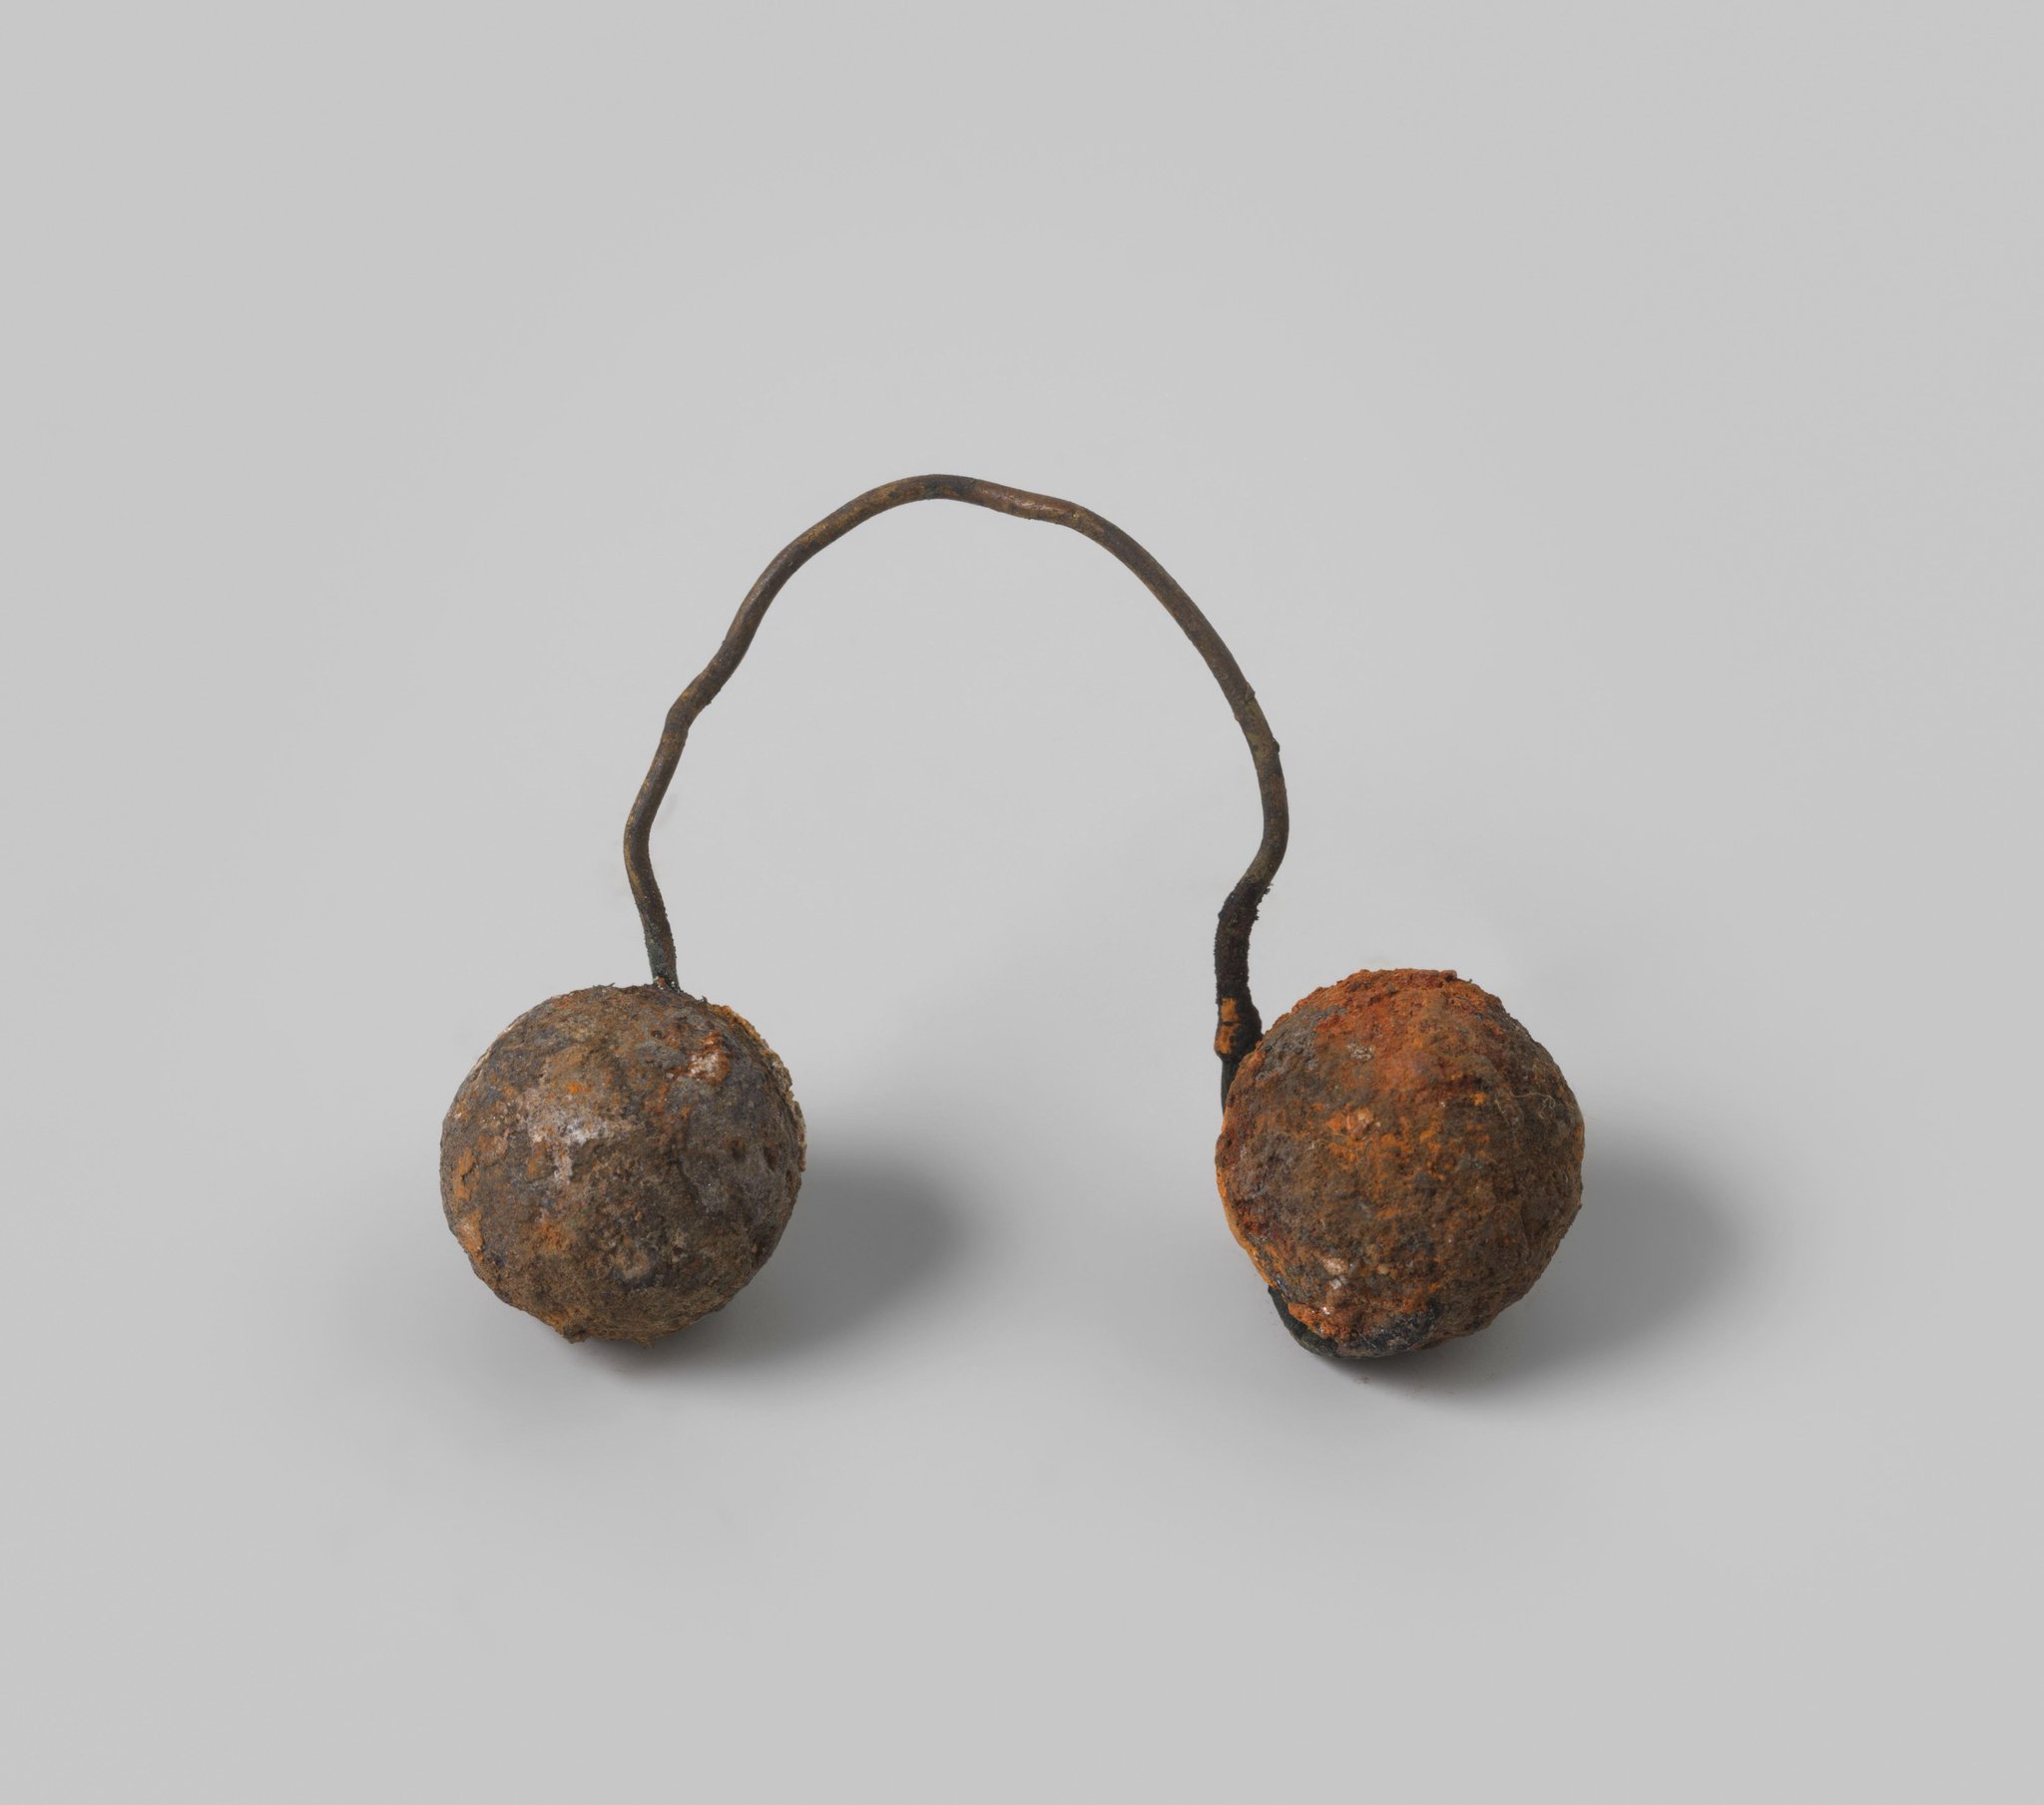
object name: chain shot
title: Kettingkogel uit het wrak van de Oost-Indiëvaarder Hollandia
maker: Anonymous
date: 1700-1743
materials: lead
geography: netherlands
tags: verenigde oostindische compagnie, hollandia (schip), annet